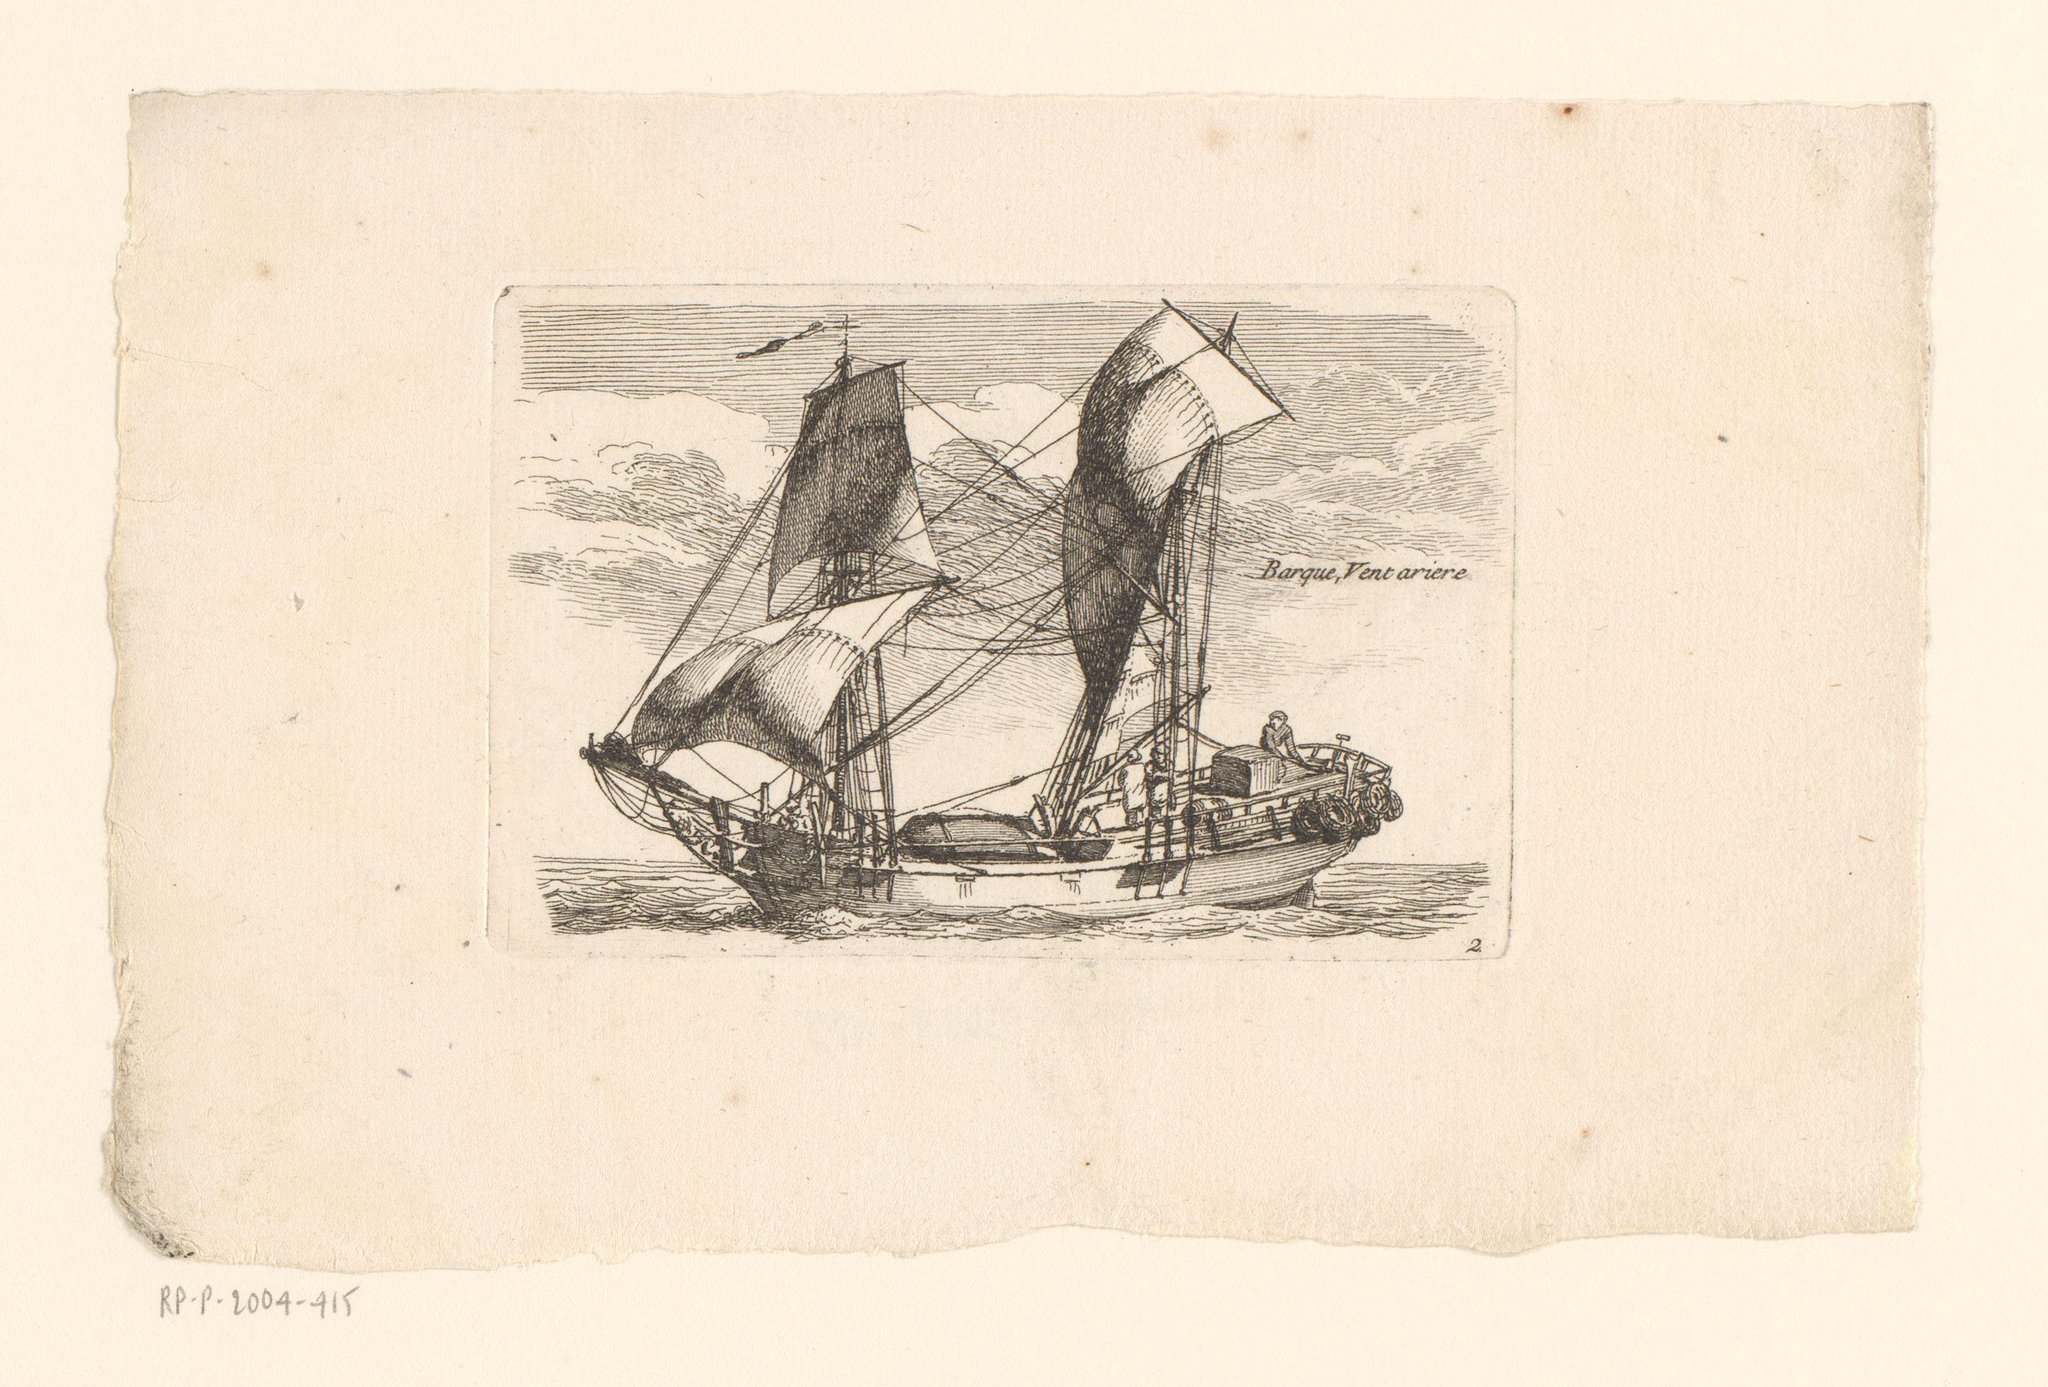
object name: print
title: Zeilboot met wind tegen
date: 1738-1811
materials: paper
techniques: etching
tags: sailing-ship, sailing-boat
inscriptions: collector's mark: Lugt 2228, collector's mark: Lugt 2760